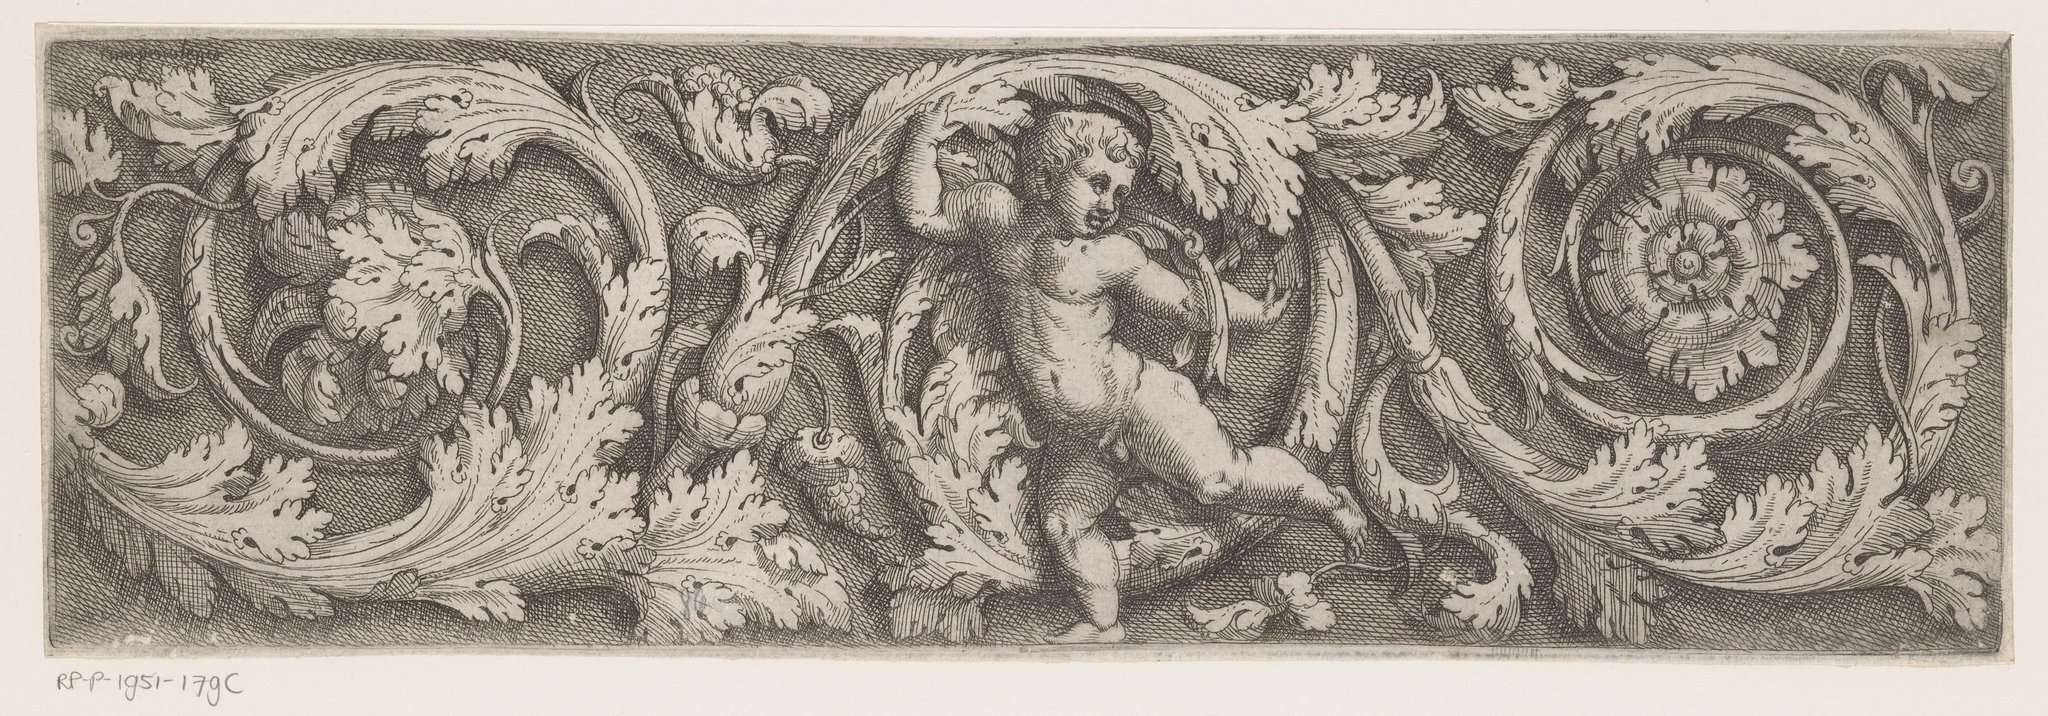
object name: ornament print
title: Ornamentele friezen met arabesken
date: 1561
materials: paper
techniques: etching, intaglio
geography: venice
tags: ornaments ~ art, foliage ~ ornament, cupids: 'amores', 'amoretti', 'putti'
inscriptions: collector's mark: Lugt 2228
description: Deze prent maakt onderdeel uit van een reeks.